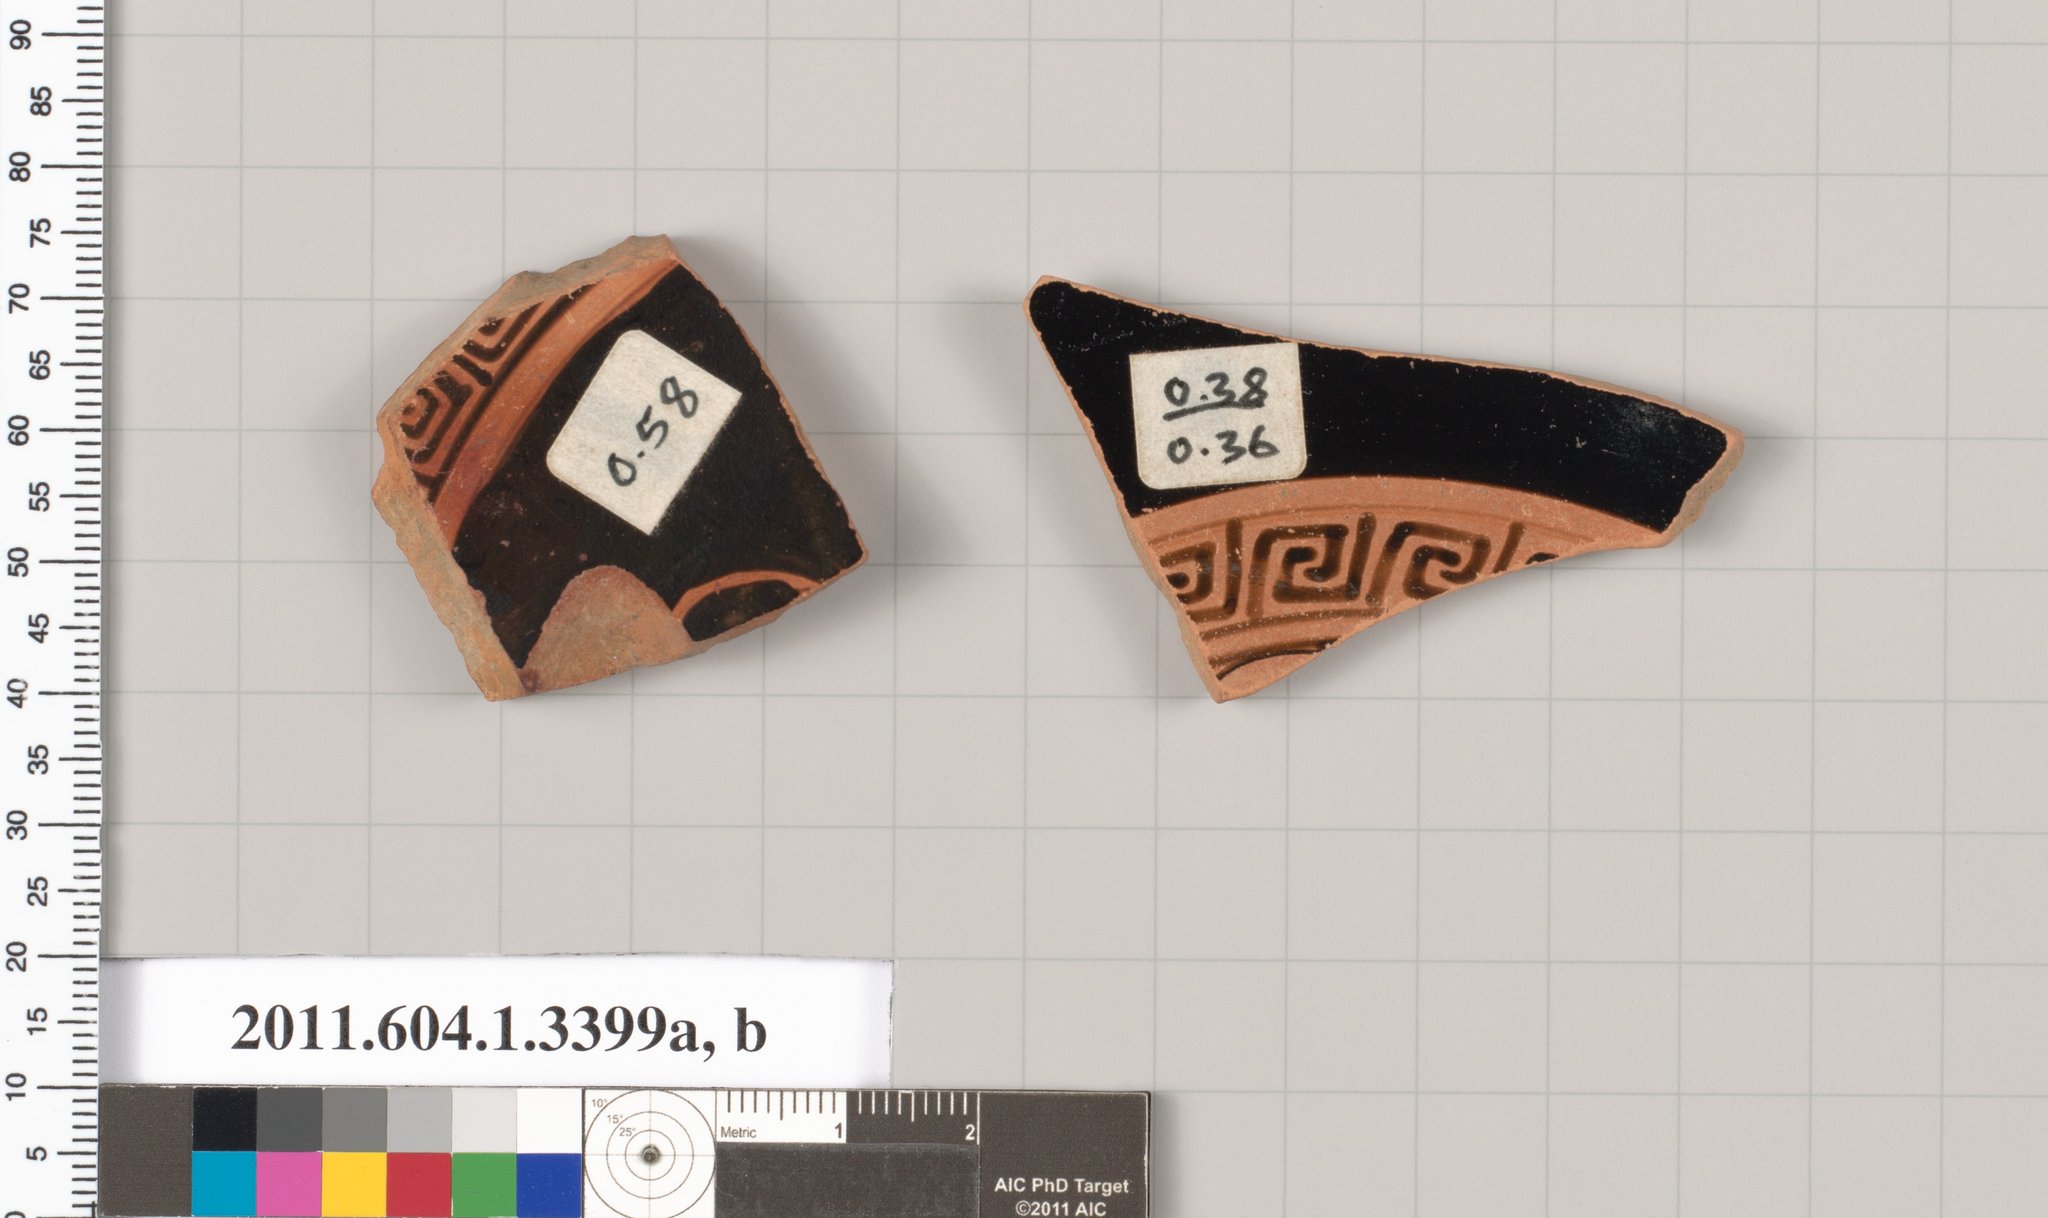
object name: kylix fragment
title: Terracotta fragments of kylikes (drinking cups)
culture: greek, attic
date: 500-470 BCE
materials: terracotta